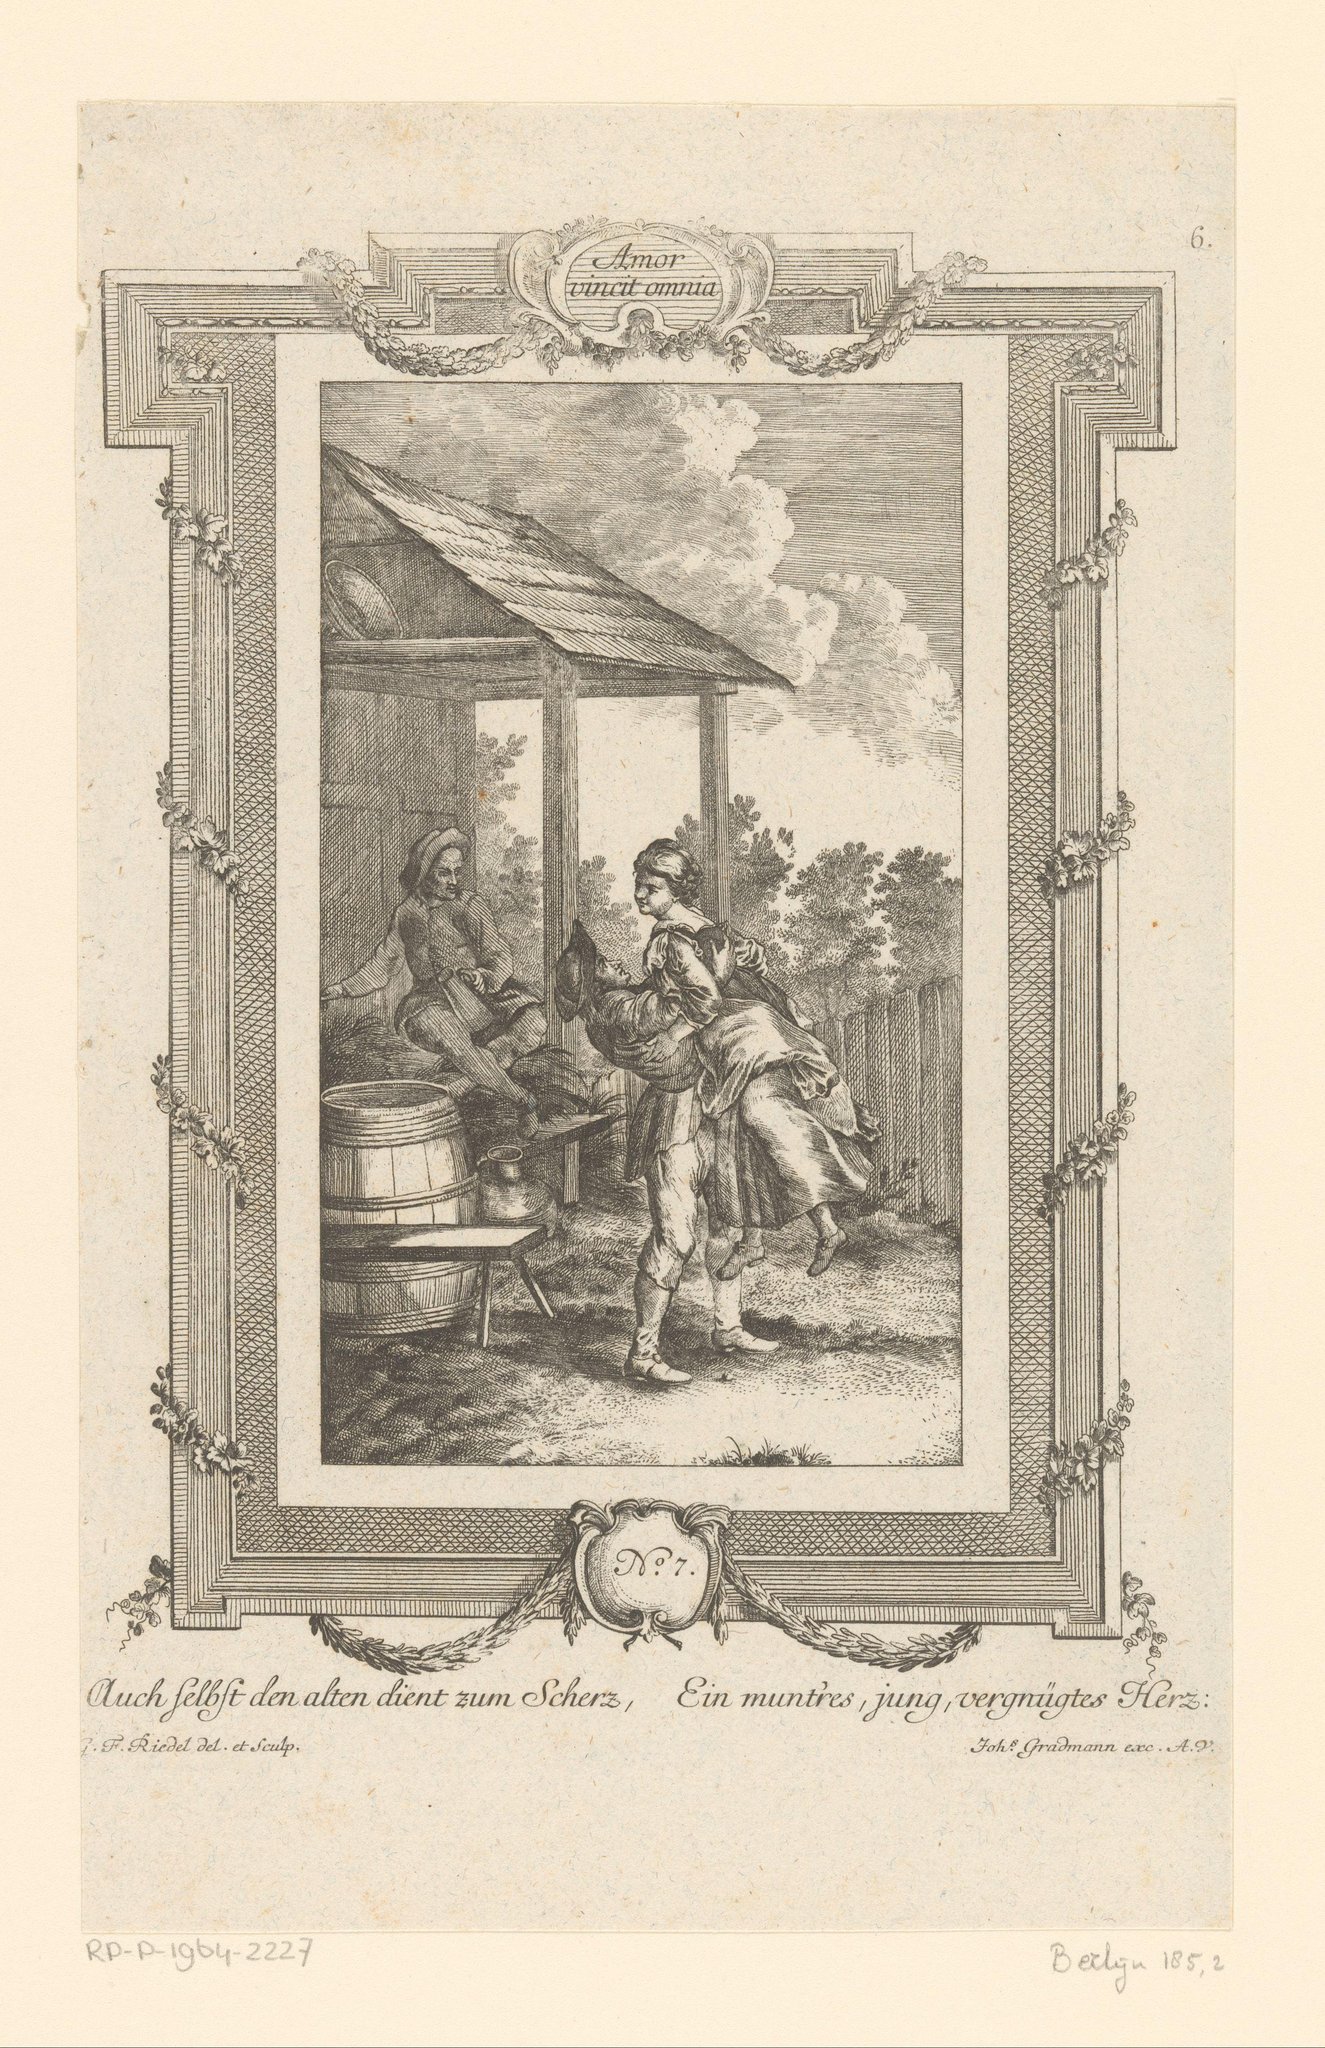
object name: print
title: Pastorale liefdesscènes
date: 1778-1779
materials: paper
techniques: etching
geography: augsburg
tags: pastorals, arcadian scenes, couple of lovers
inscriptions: collector's mark: Lugt 2228, collector's mark: Lugt 2760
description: Een man tilt zijn geliefde op. Links onder een overkapping kijkt een man naar het verliefde stel. Rondom de voorstelling een omlijsting met guirlandes. In de ondermarge een Duitse tekst. Uitgeversnummer 7.